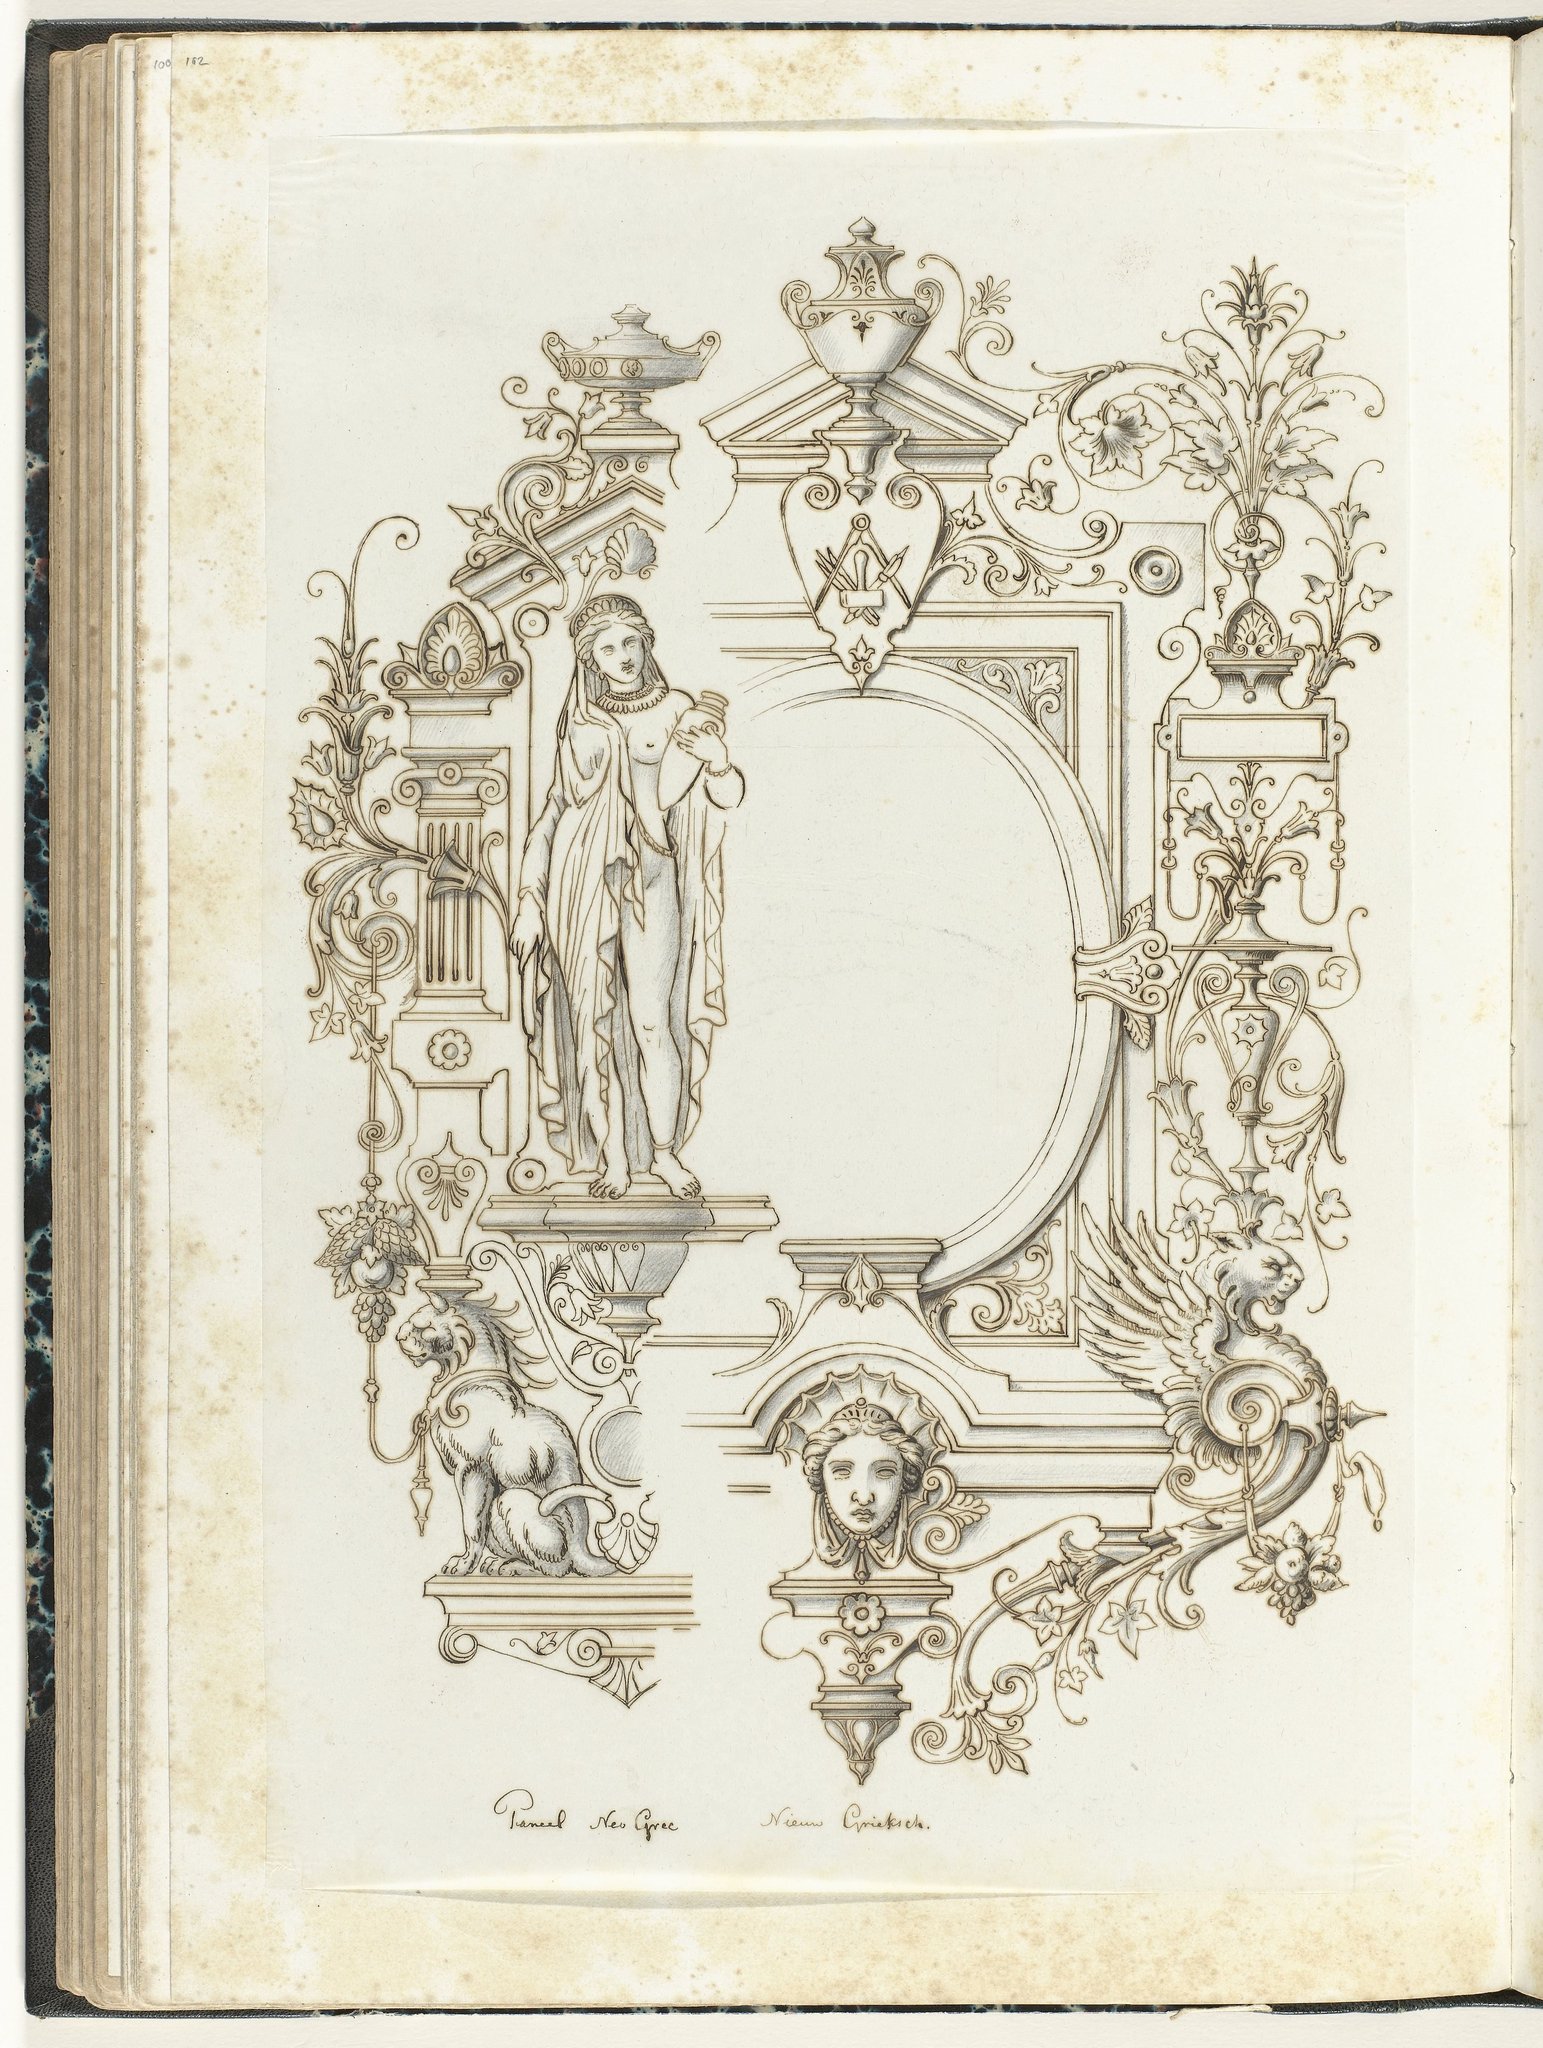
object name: drawing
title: Paneel Neo Grec / Nieuw Grieksch.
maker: Anonymous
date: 1866-1900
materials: pencil, paper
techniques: drawing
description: Twee decoraties, links met het beeld van een vrouw die een vaas vasthoudt, rechts met een cartouche waaronder een vrouwenhoofd hangt .